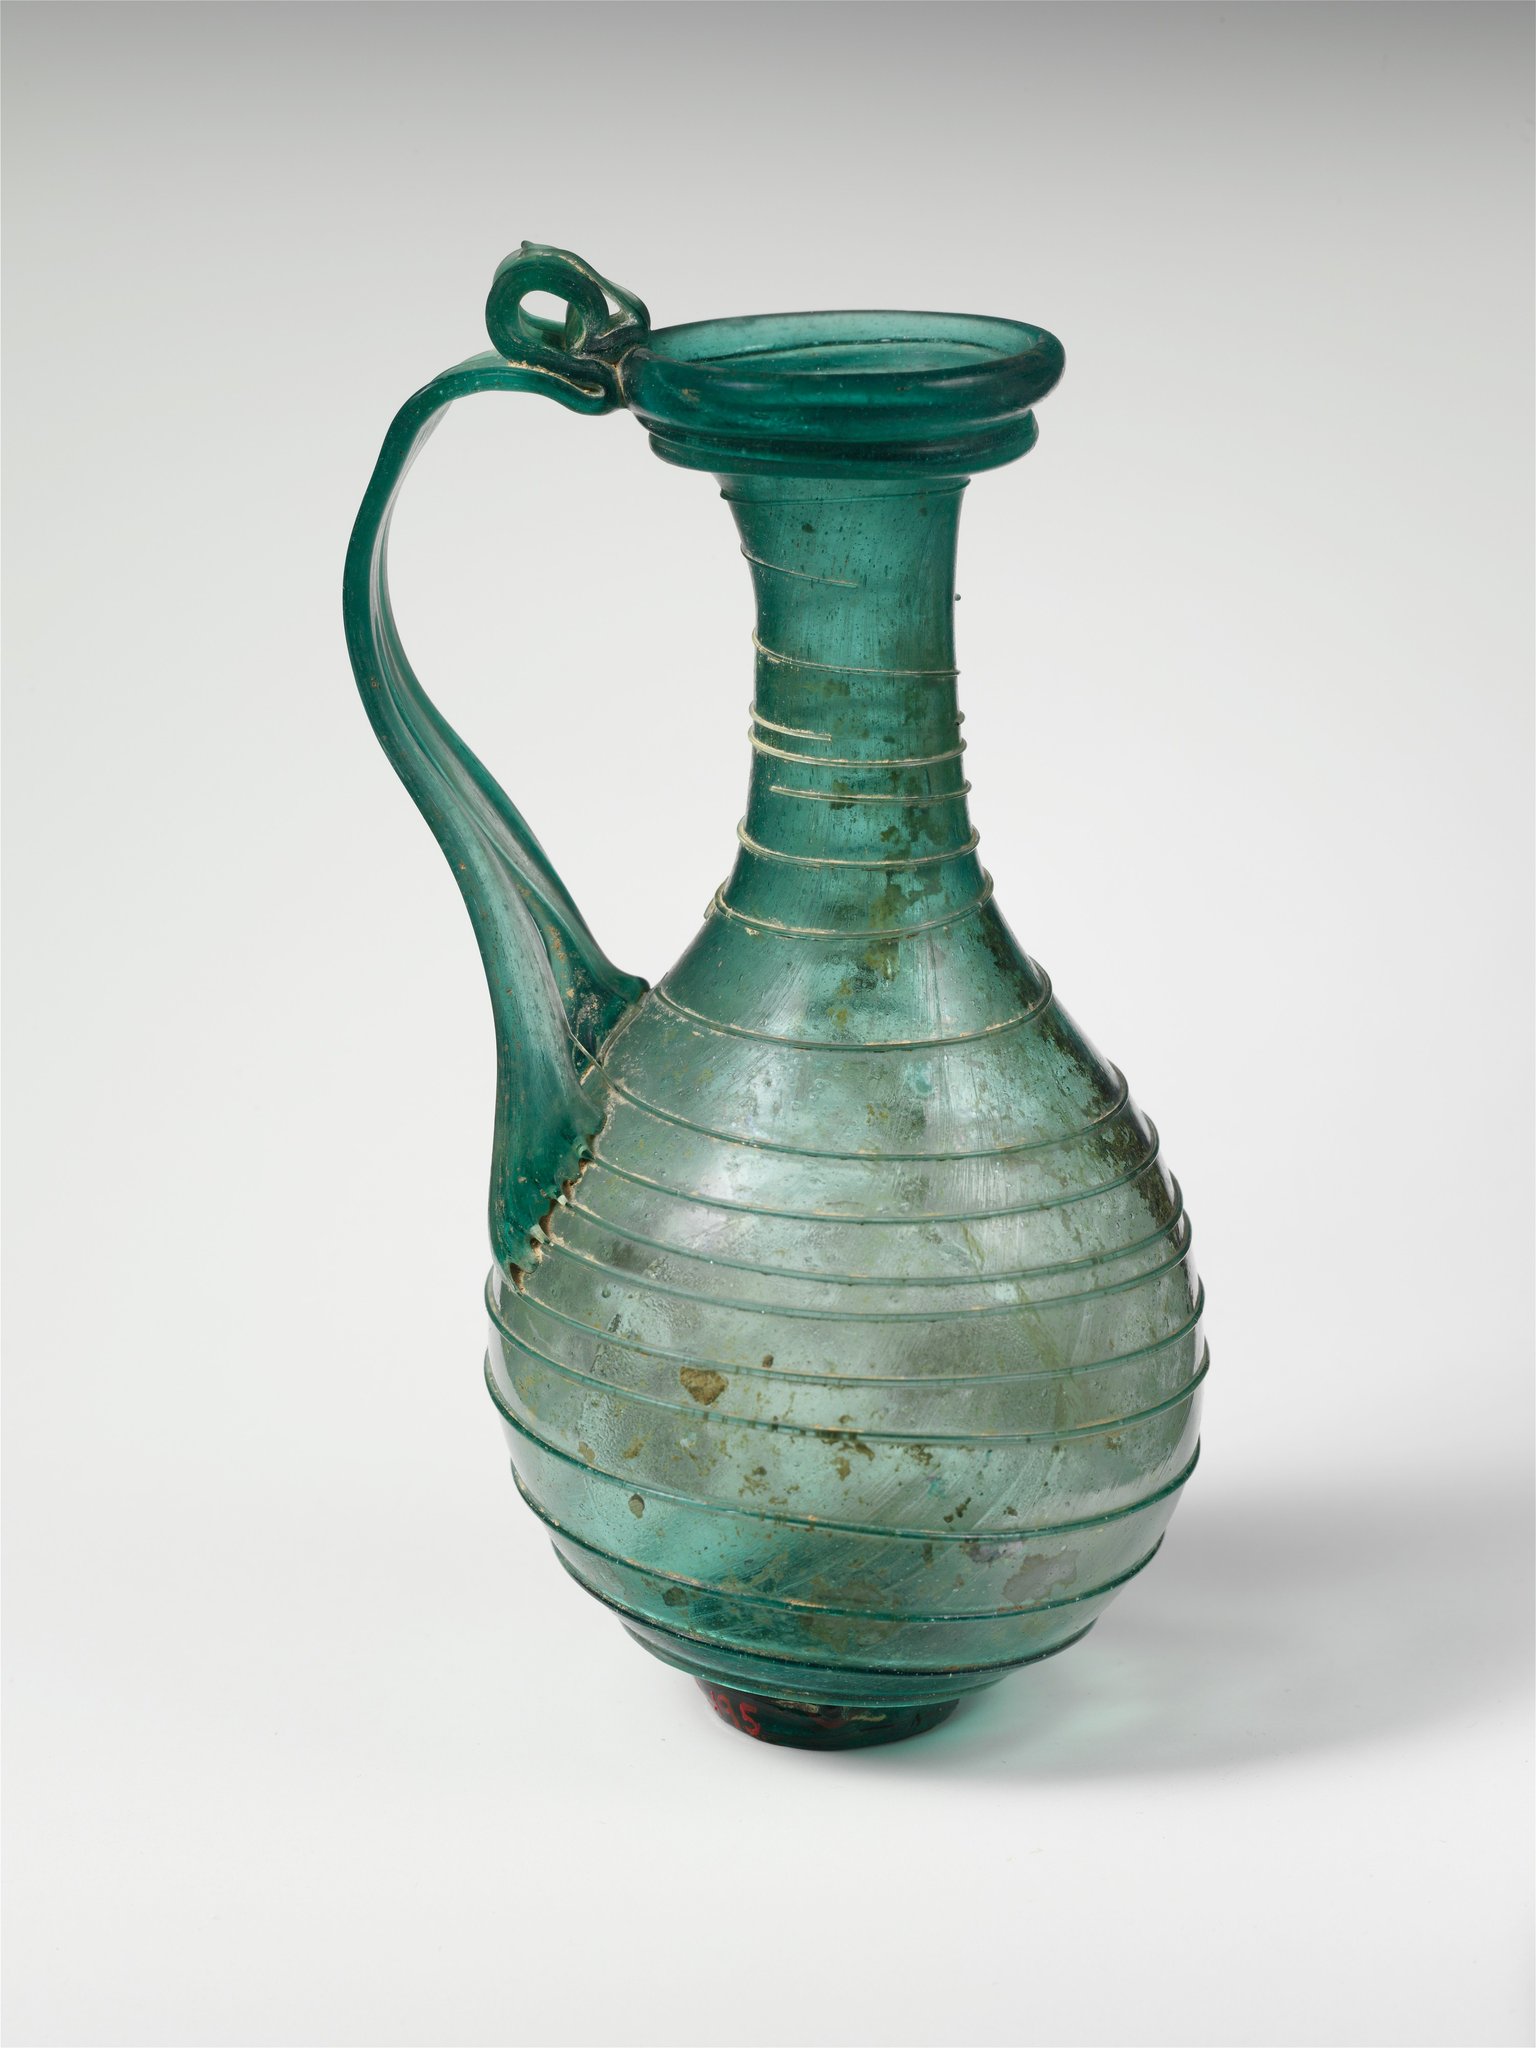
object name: jug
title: Glass jug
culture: roman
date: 201-400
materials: glass